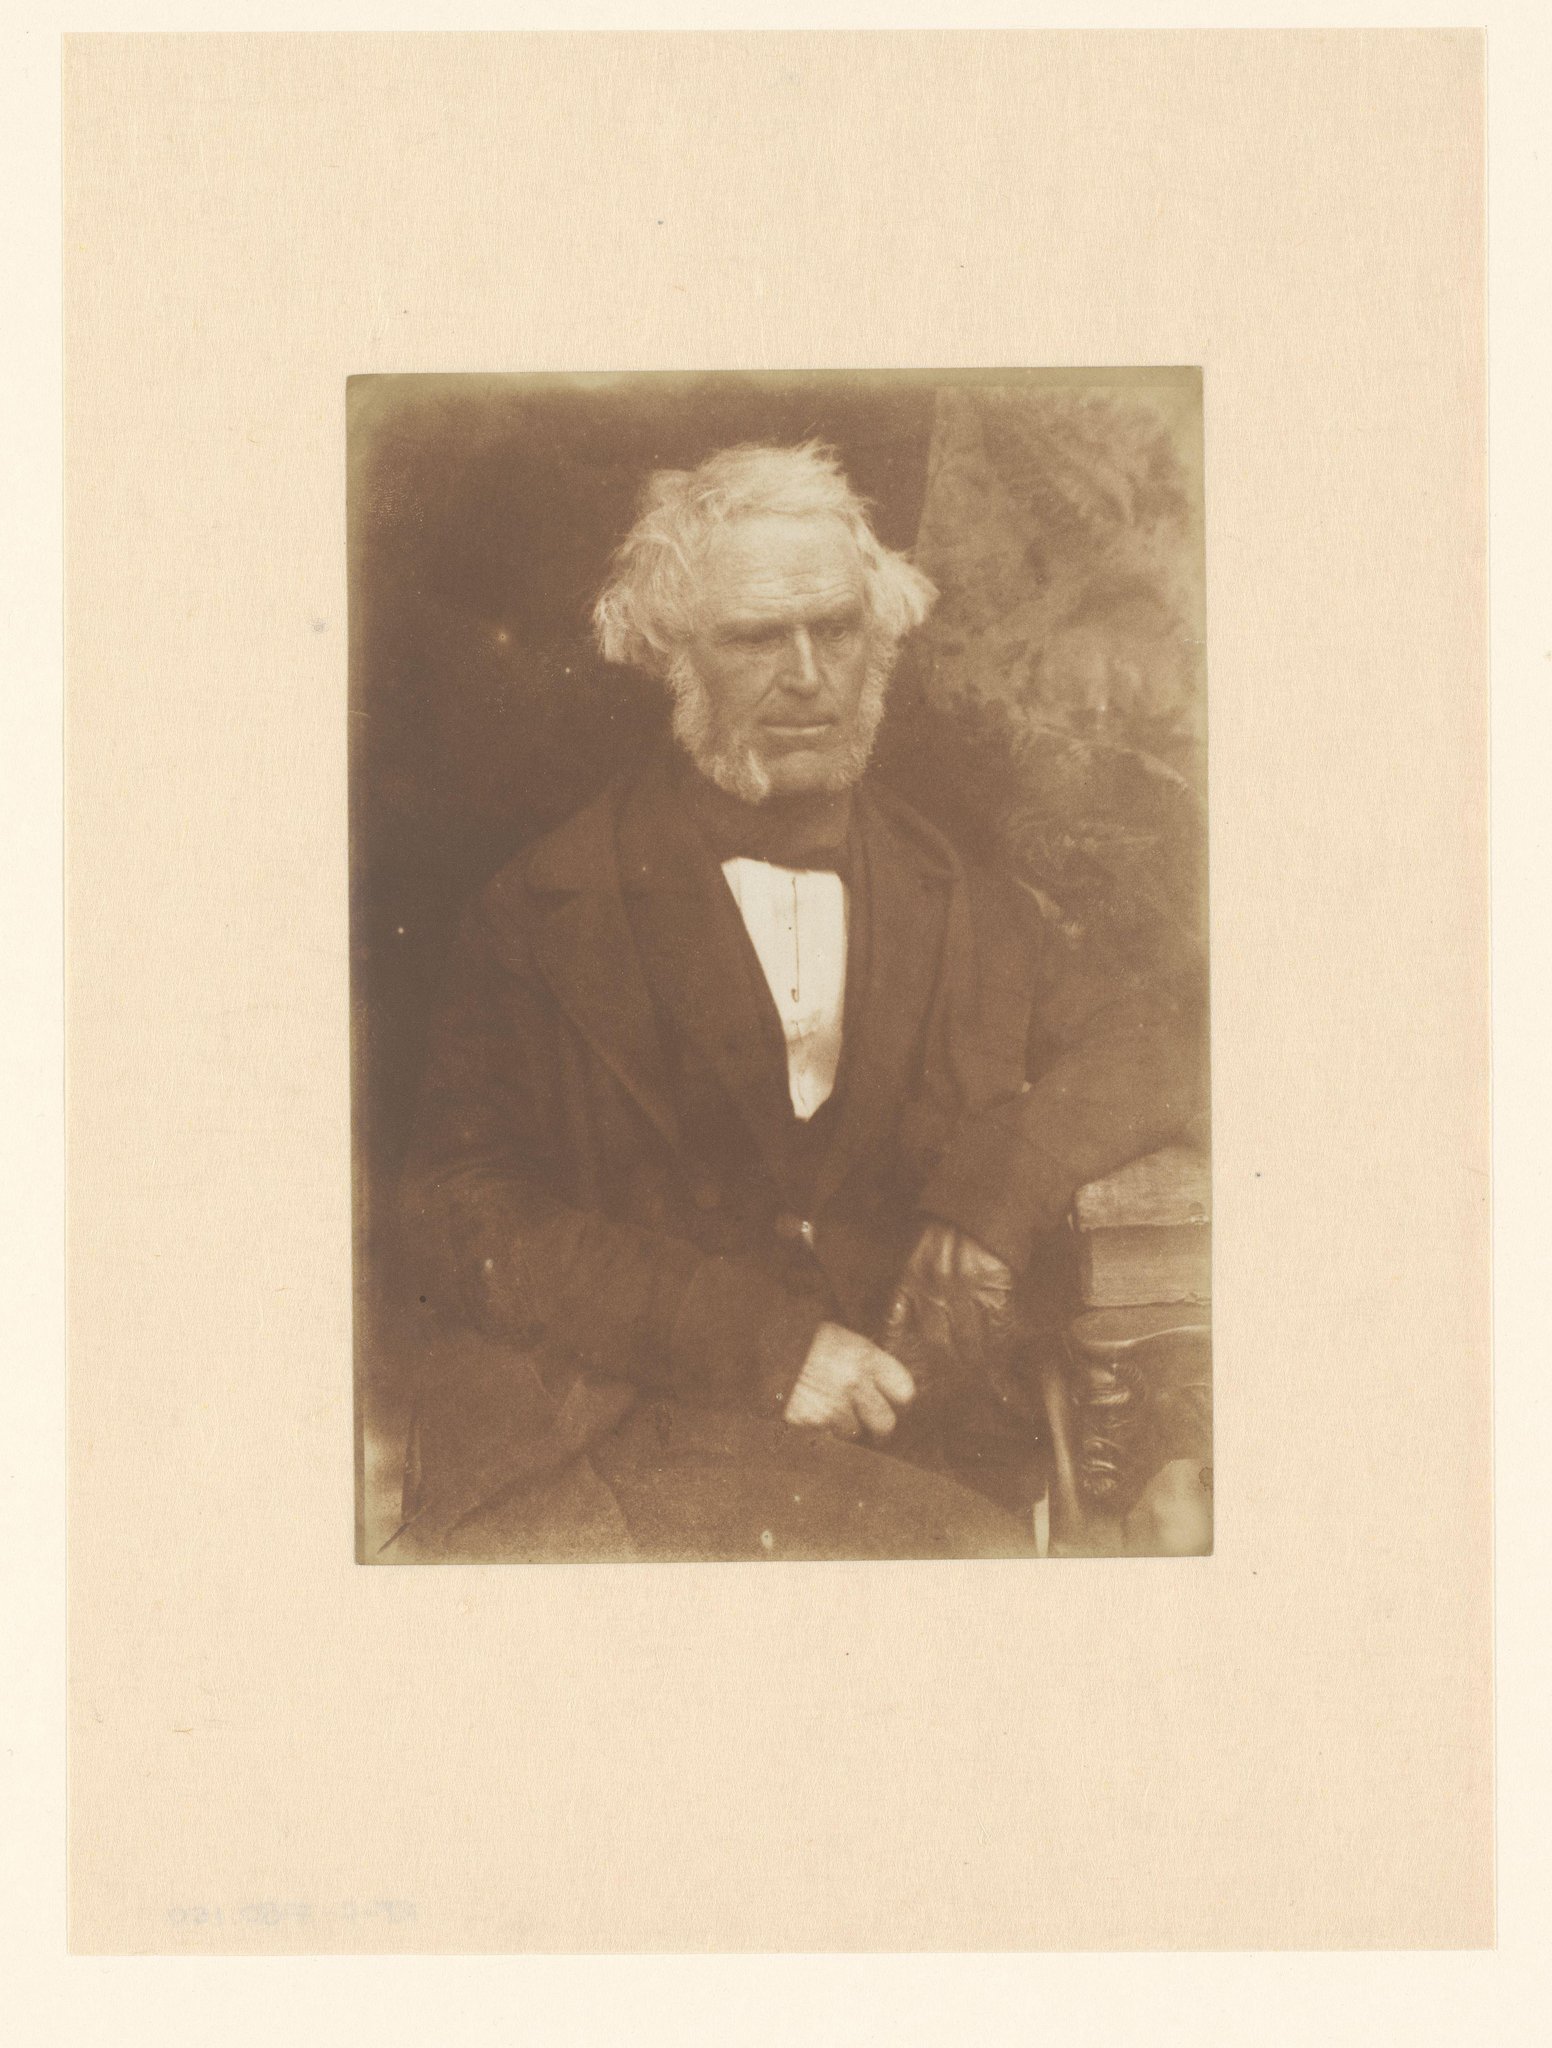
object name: photograph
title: Portret van een man, aangeduid als rev. A.B. Parker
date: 1843-1847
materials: photographic support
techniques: salted paper print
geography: edinburgh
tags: functionaries and dignitaries (with name) ~ protestant churches, historical persons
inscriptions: inscription: ‘Rev A B Parker/ Lesmatijo [?]/ A14’